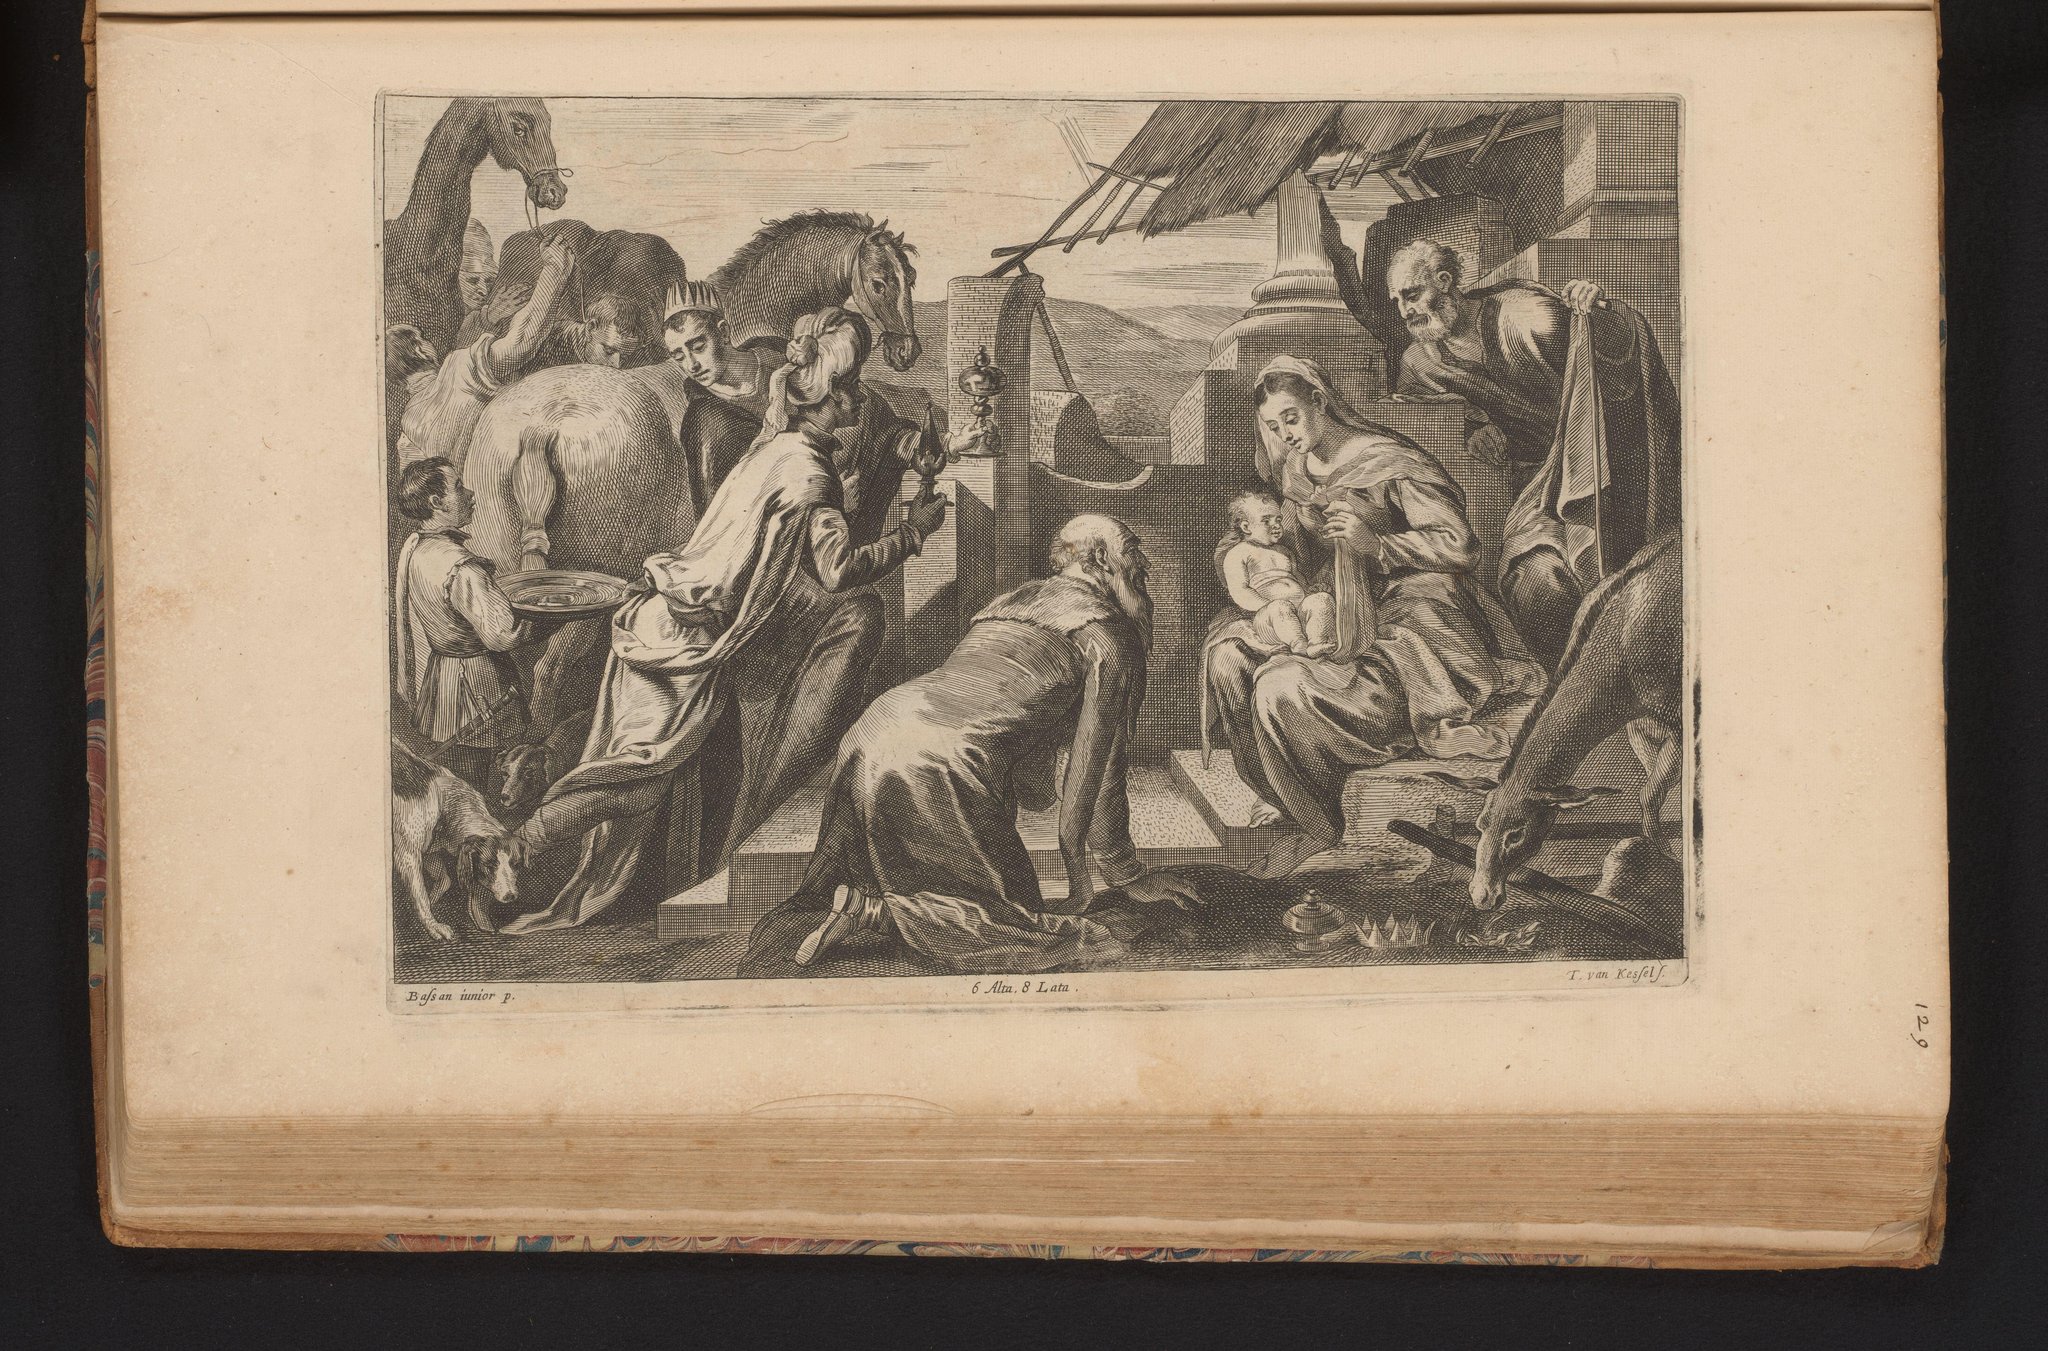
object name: album leaf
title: Aanbidding door de koningen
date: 1660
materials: paper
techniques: engraving, etching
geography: southern netherlands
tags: adoration of the kings: the wise men present their gifts to the christ-child (gold, frankincense and myrrh)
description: David Teniers heeft waarschijnlijk van alle schilderijen uit de collectie van Leopold Willem van Oostenrijk een olieverfstudie op doek of paneel vervaardigd (zgn. pasticcio), die als voorbeeld voor de prentmakers diende. Het is niet altijd duidelijk of de pasticci door hem zijn gemaakt of door zijn atelier. Niet alle pasticci zijn overgeleverd.